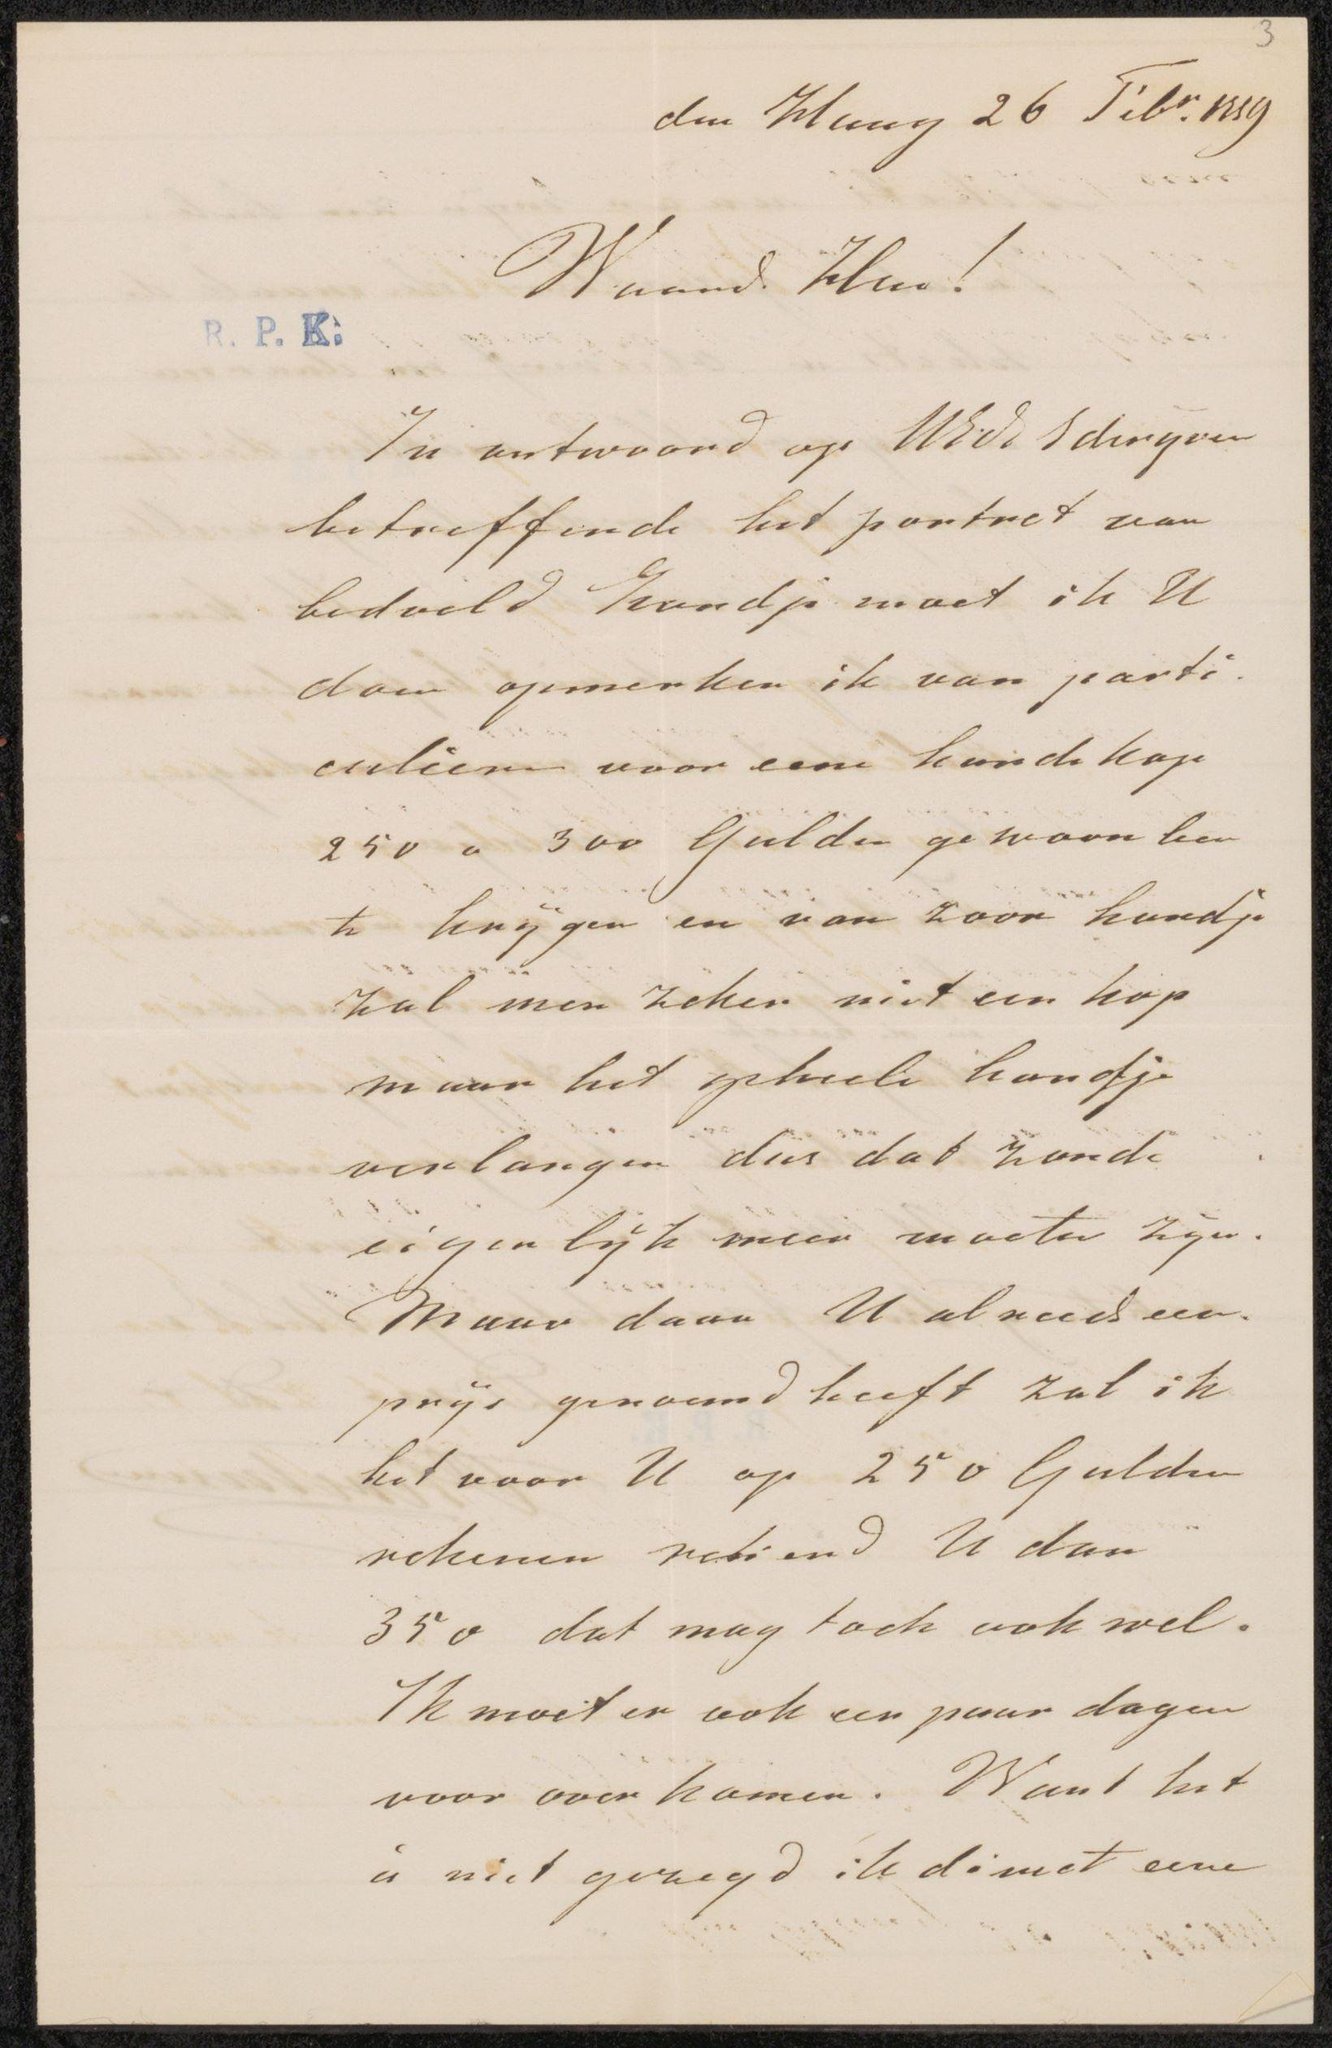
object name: letter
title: Brief aan Frans Buffa en Zonen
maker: otto eerelman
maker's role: draughtsman, painter, print maker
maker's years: 1839-1926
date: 1889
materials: ink, paper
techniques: pen, writing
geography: the hague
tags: publisher, drawing, money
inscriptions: collector's mark: Lugt 2233